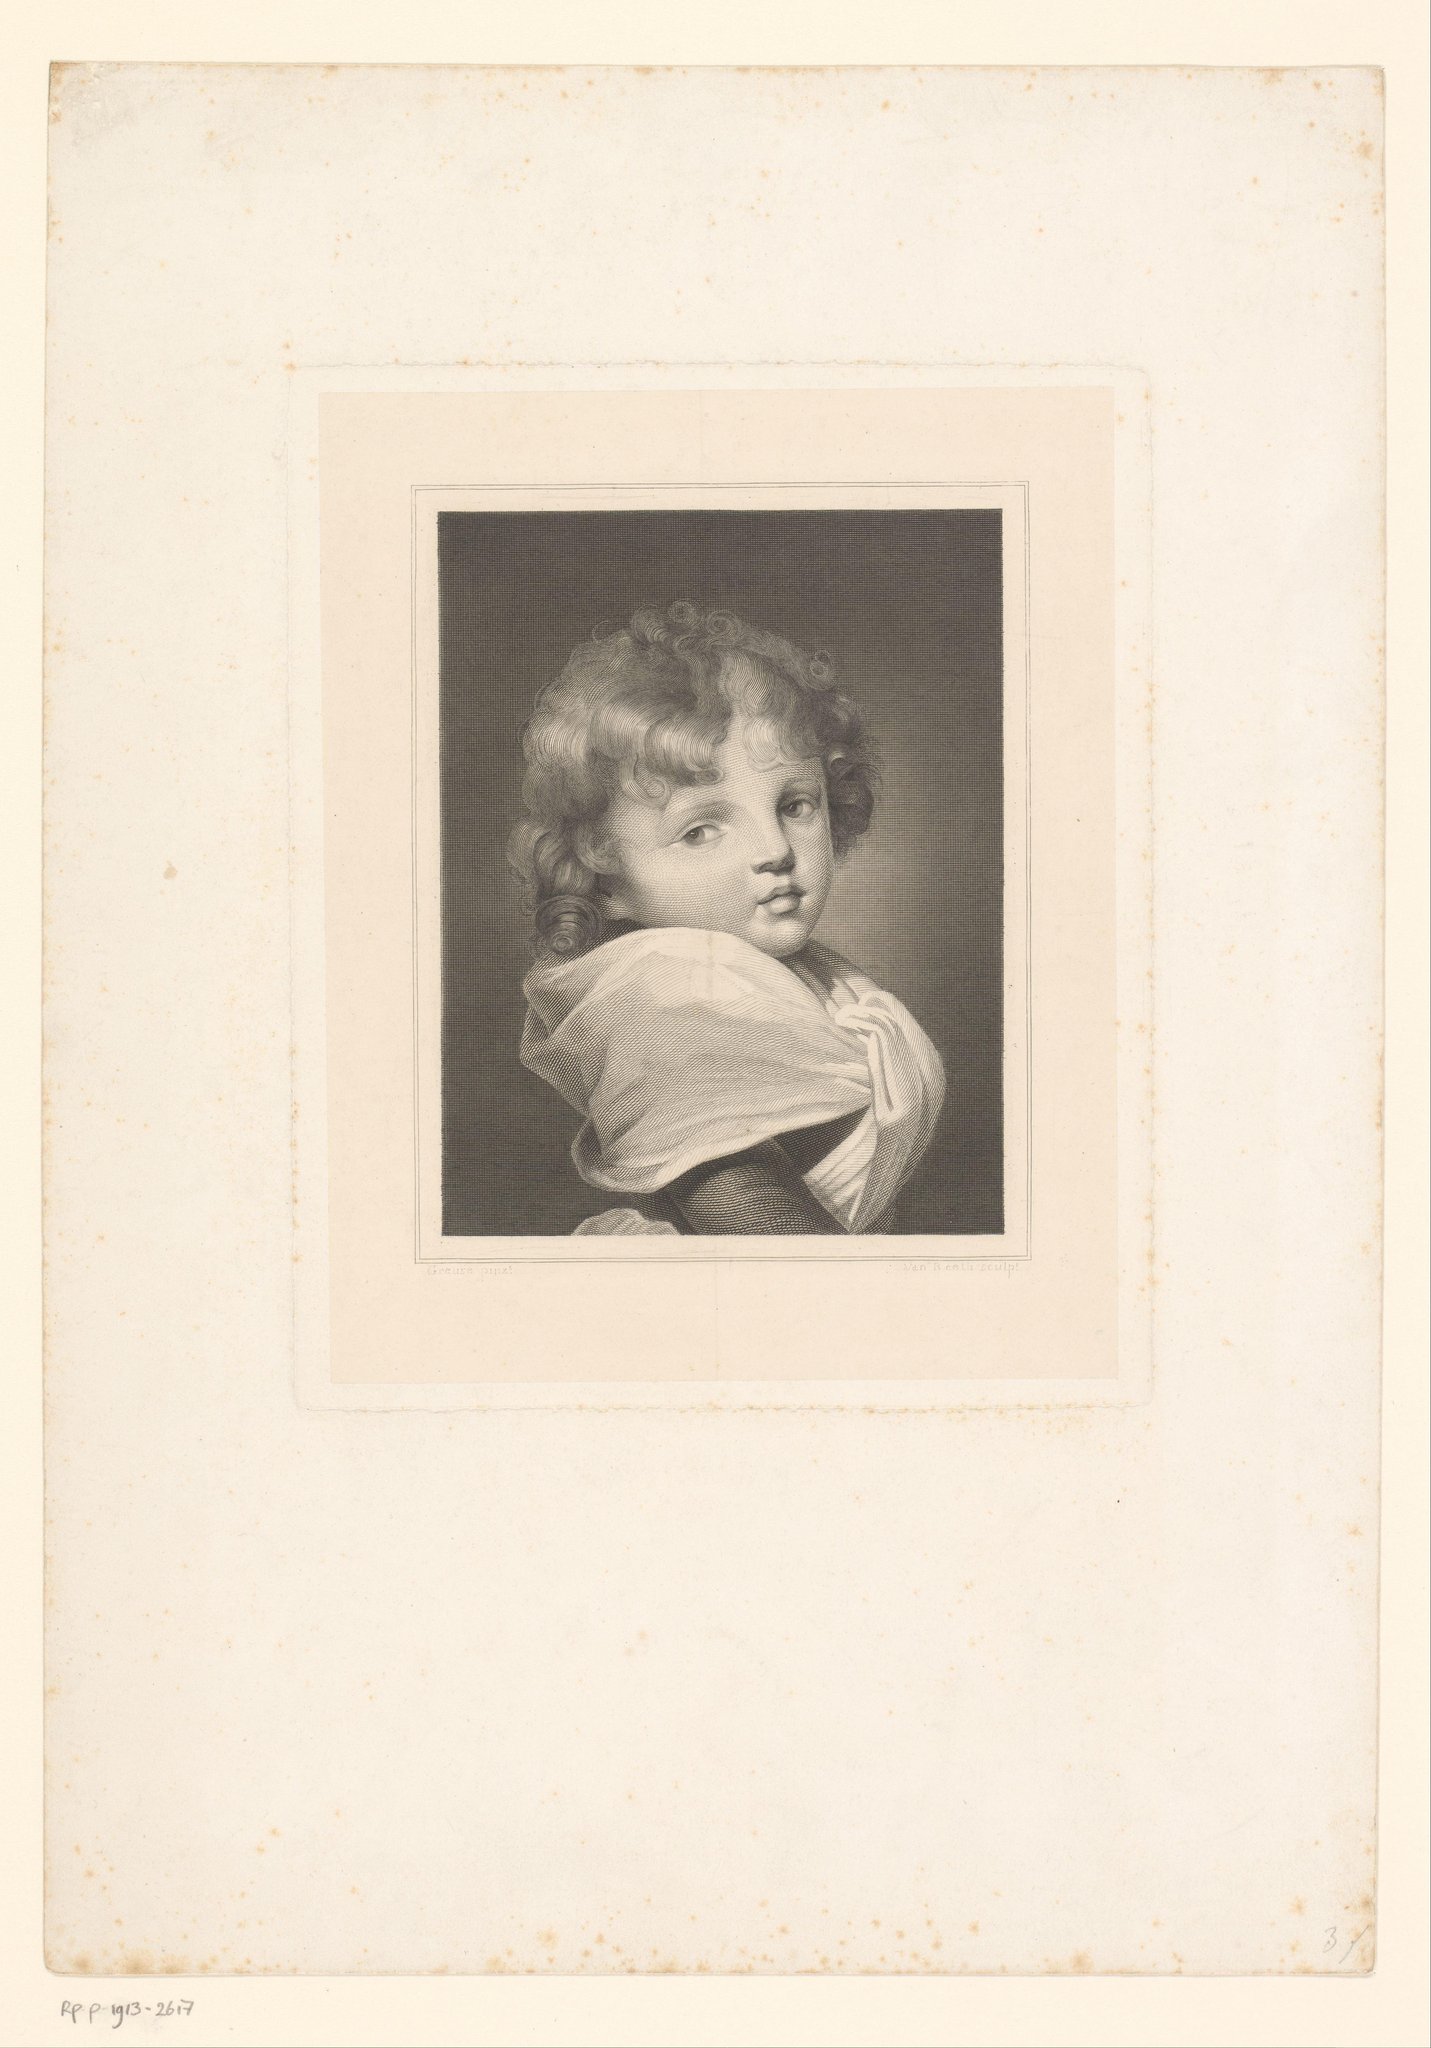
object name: print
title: Portret van een onbekend meisje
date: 1832-1866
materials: paper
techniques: engraving, etching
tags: historical persons, toddler - aa - girl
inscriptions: collector's mark: Lugt 2228